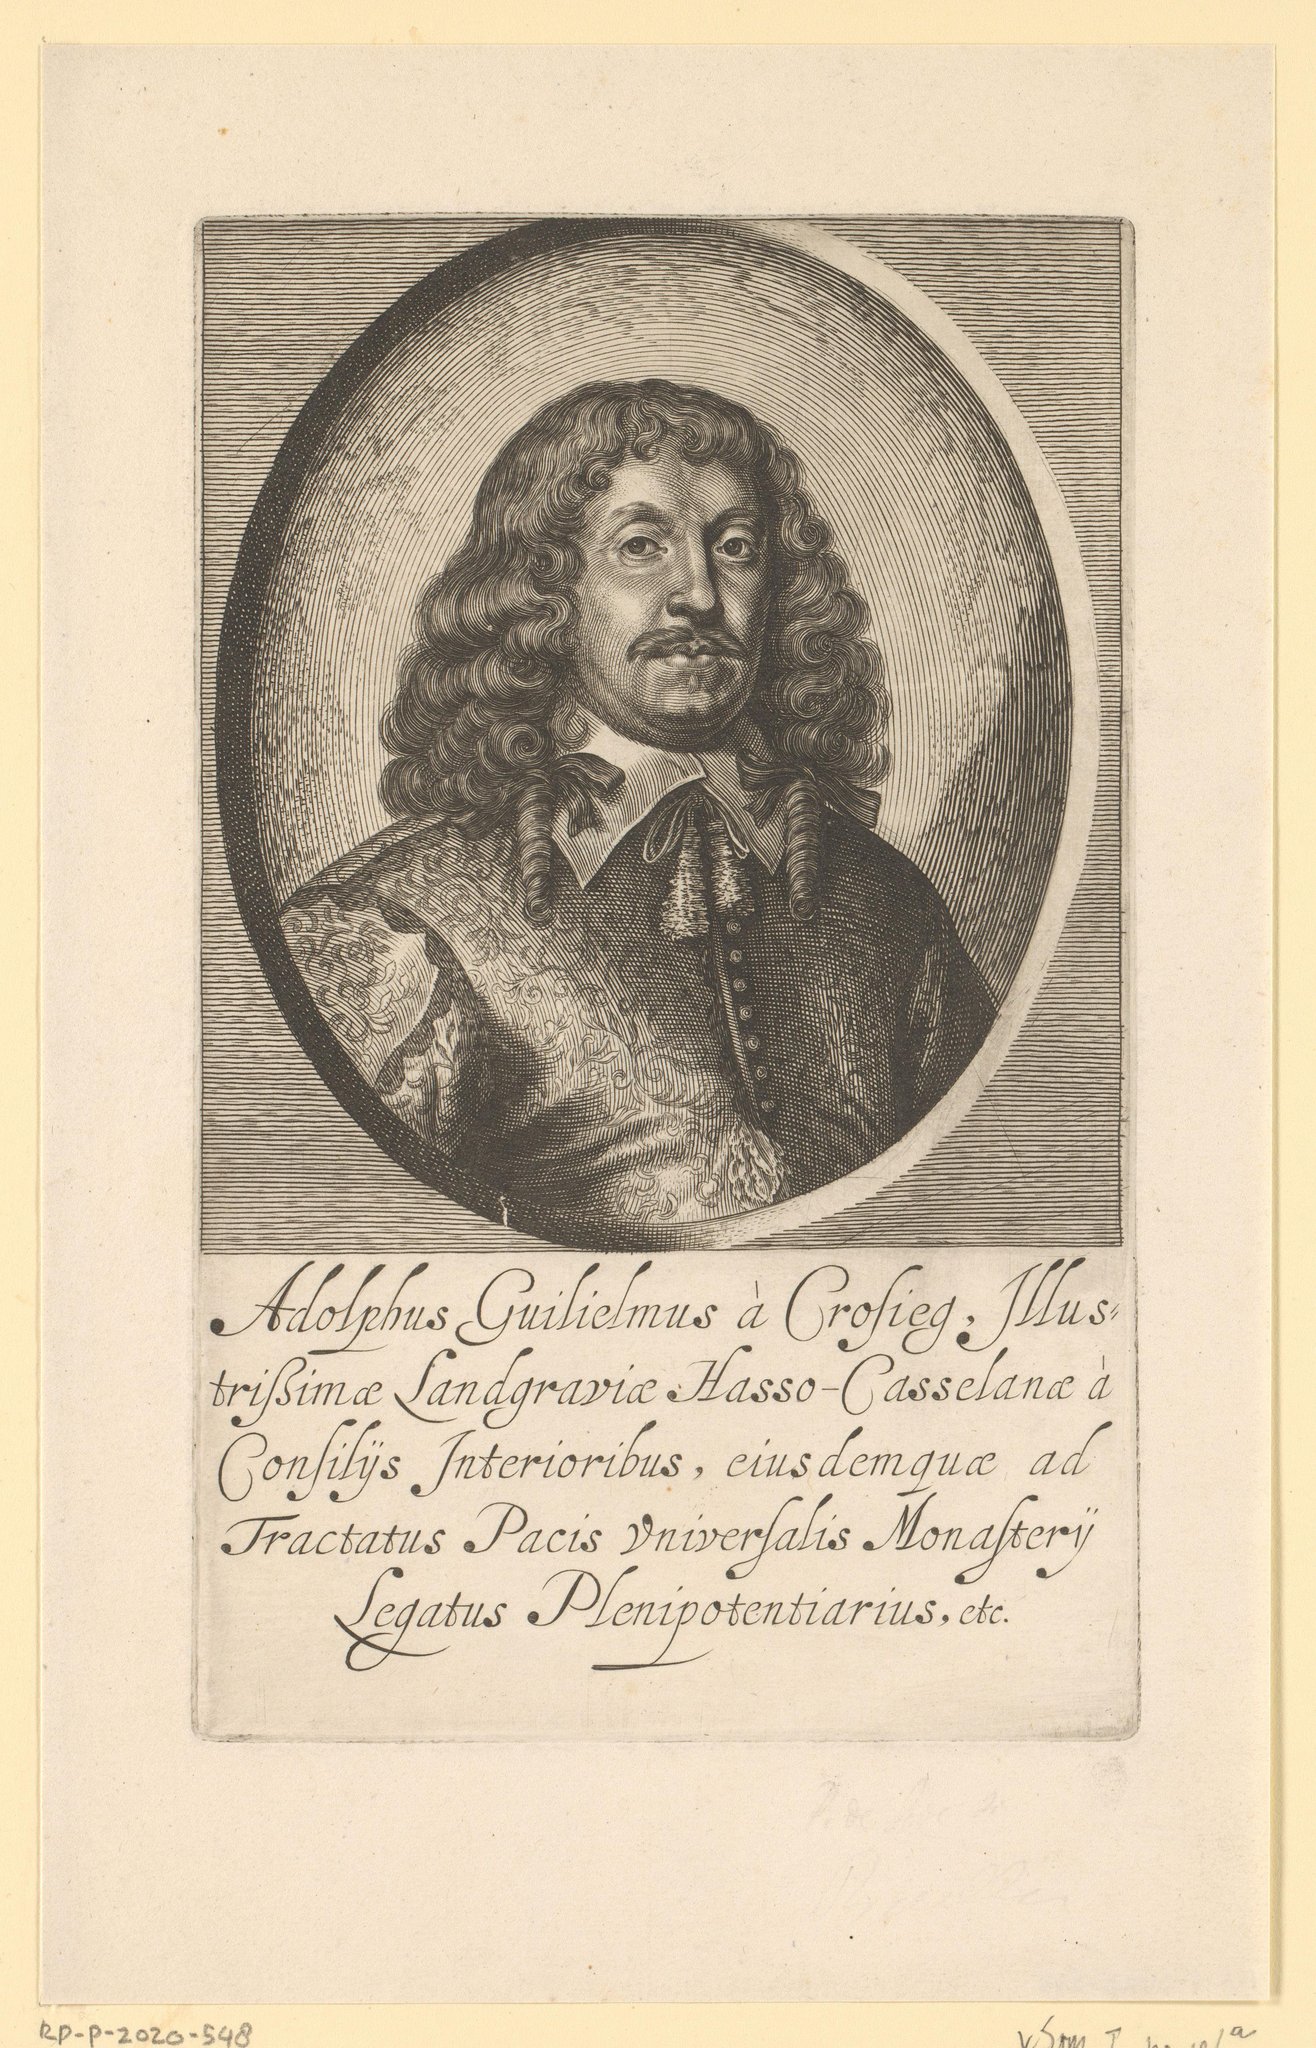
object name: print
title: Portret van diplomaat Adolf Wilhelm von Krosigk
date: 1644-1646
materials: paper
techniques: engraving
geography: amsterdam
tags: historical persons, diplomacy, diplomat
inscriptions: collector's mark: Lugt 2228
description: Prent maakt deel uit van een serie van 43 prenten. Latere staat van prent gebruikt in de serie 'Pacificatores orbis Christiani in Westphaliam missi anno 1641', uitgegeven door Rombout van den Hoeye in Amsterdam.